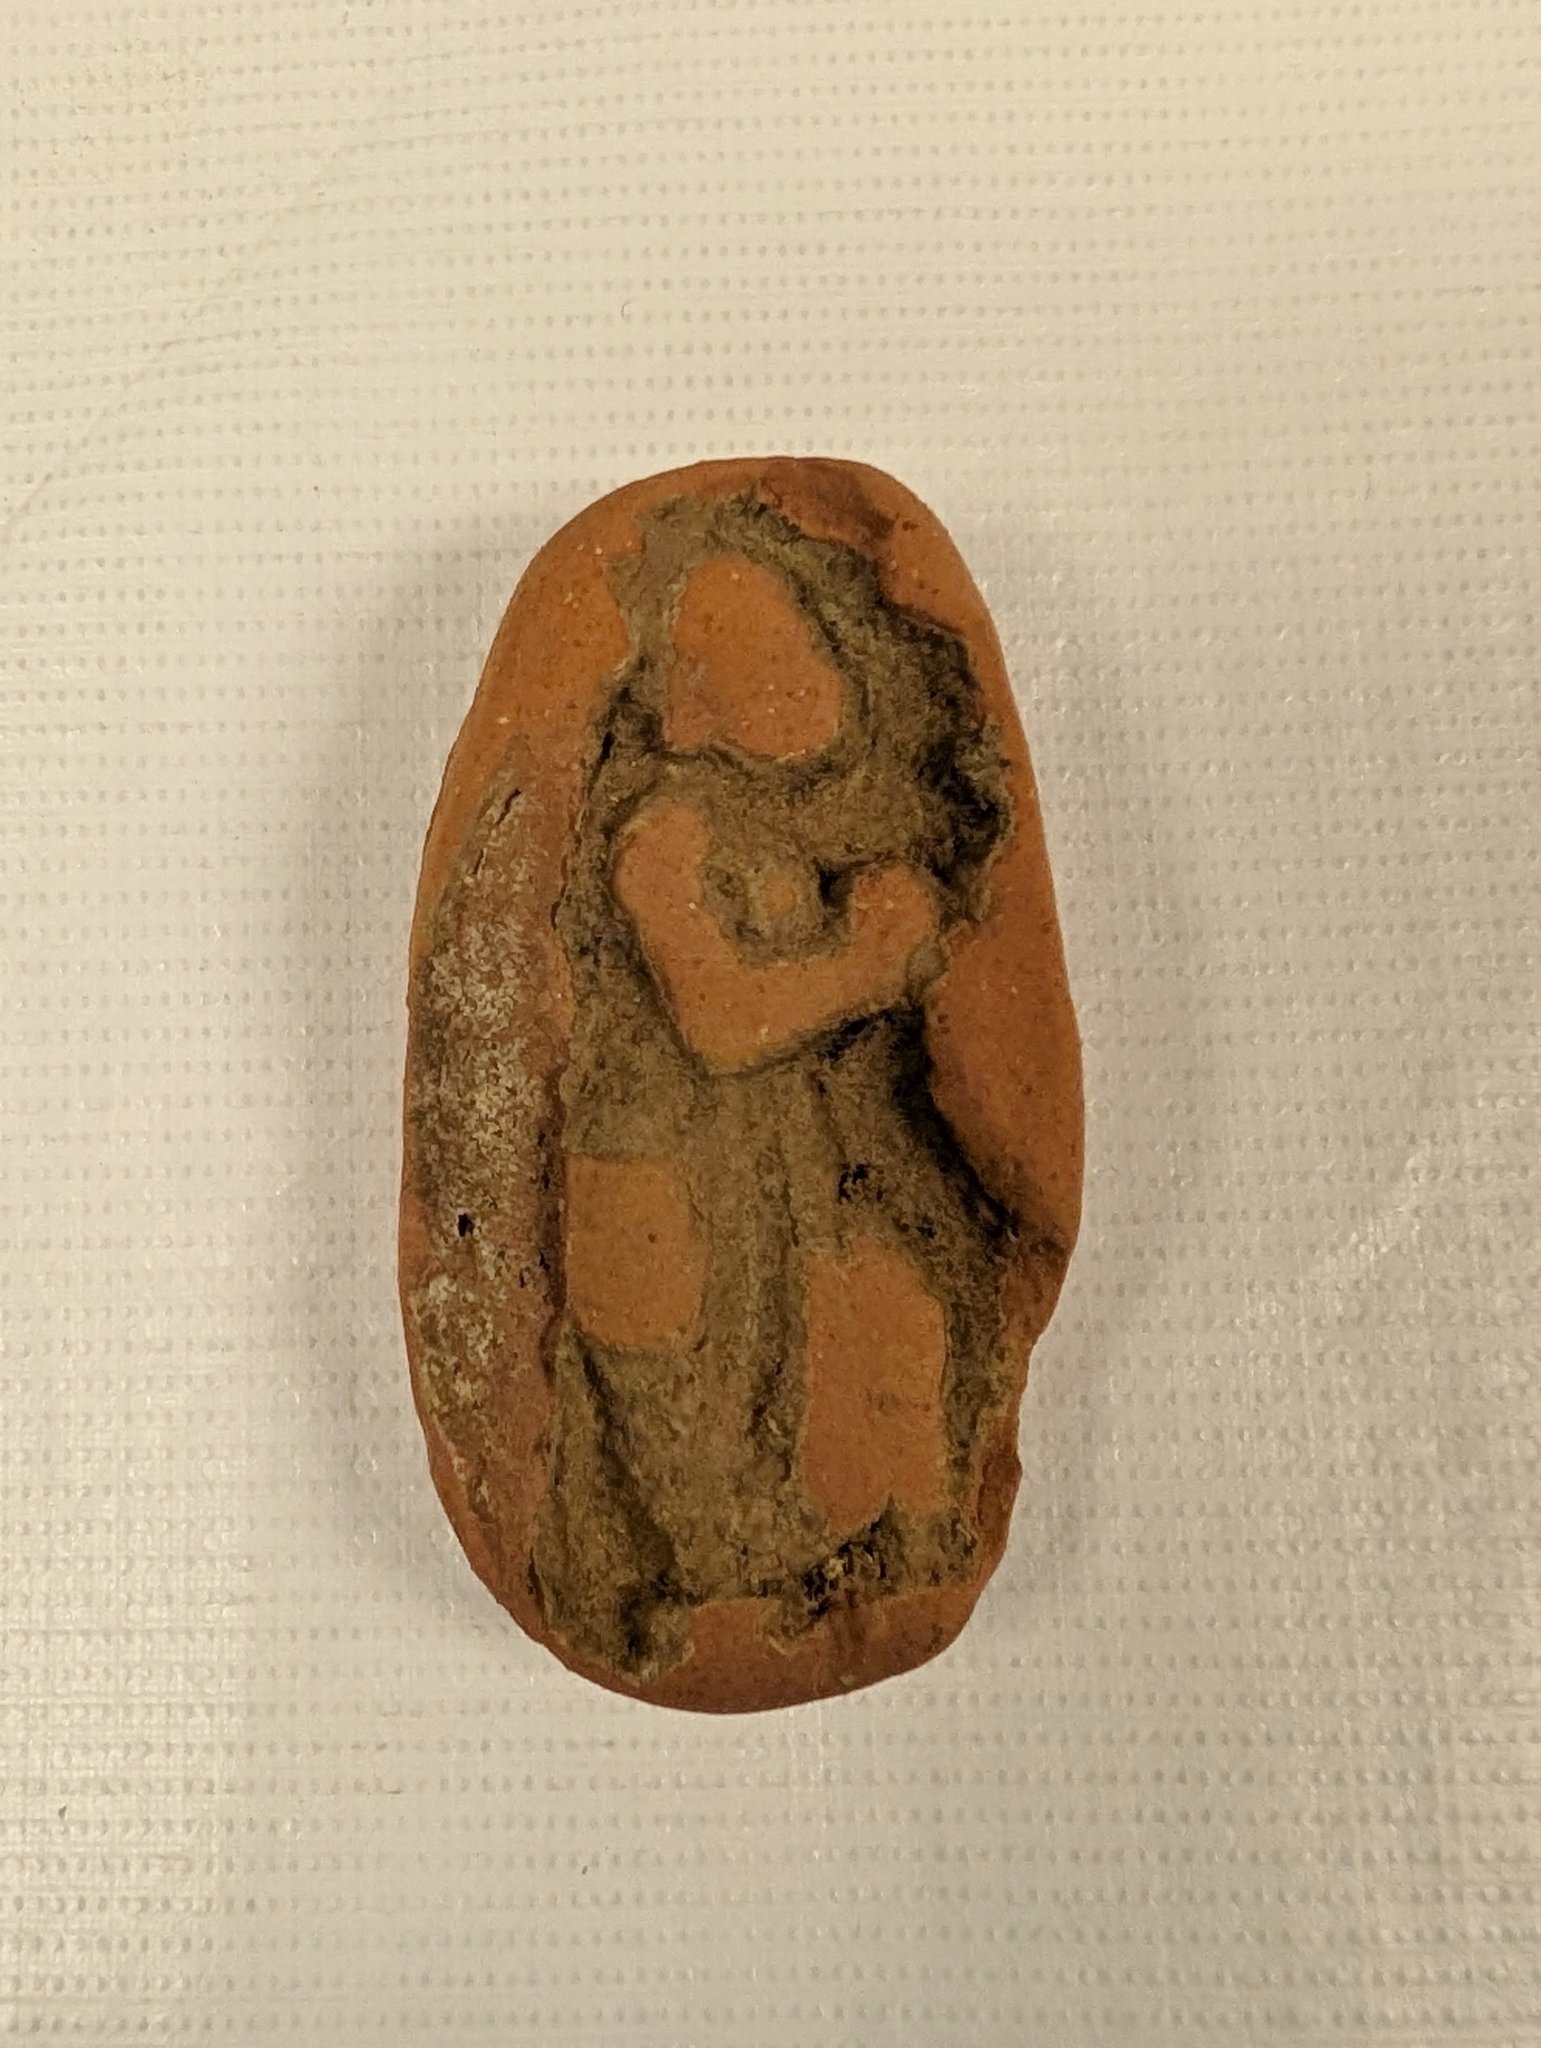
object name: plaque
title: Plaque in the Form of a Female Figure (Study Collection)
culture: pakistani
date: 101-300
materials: terracotta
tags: gandhara